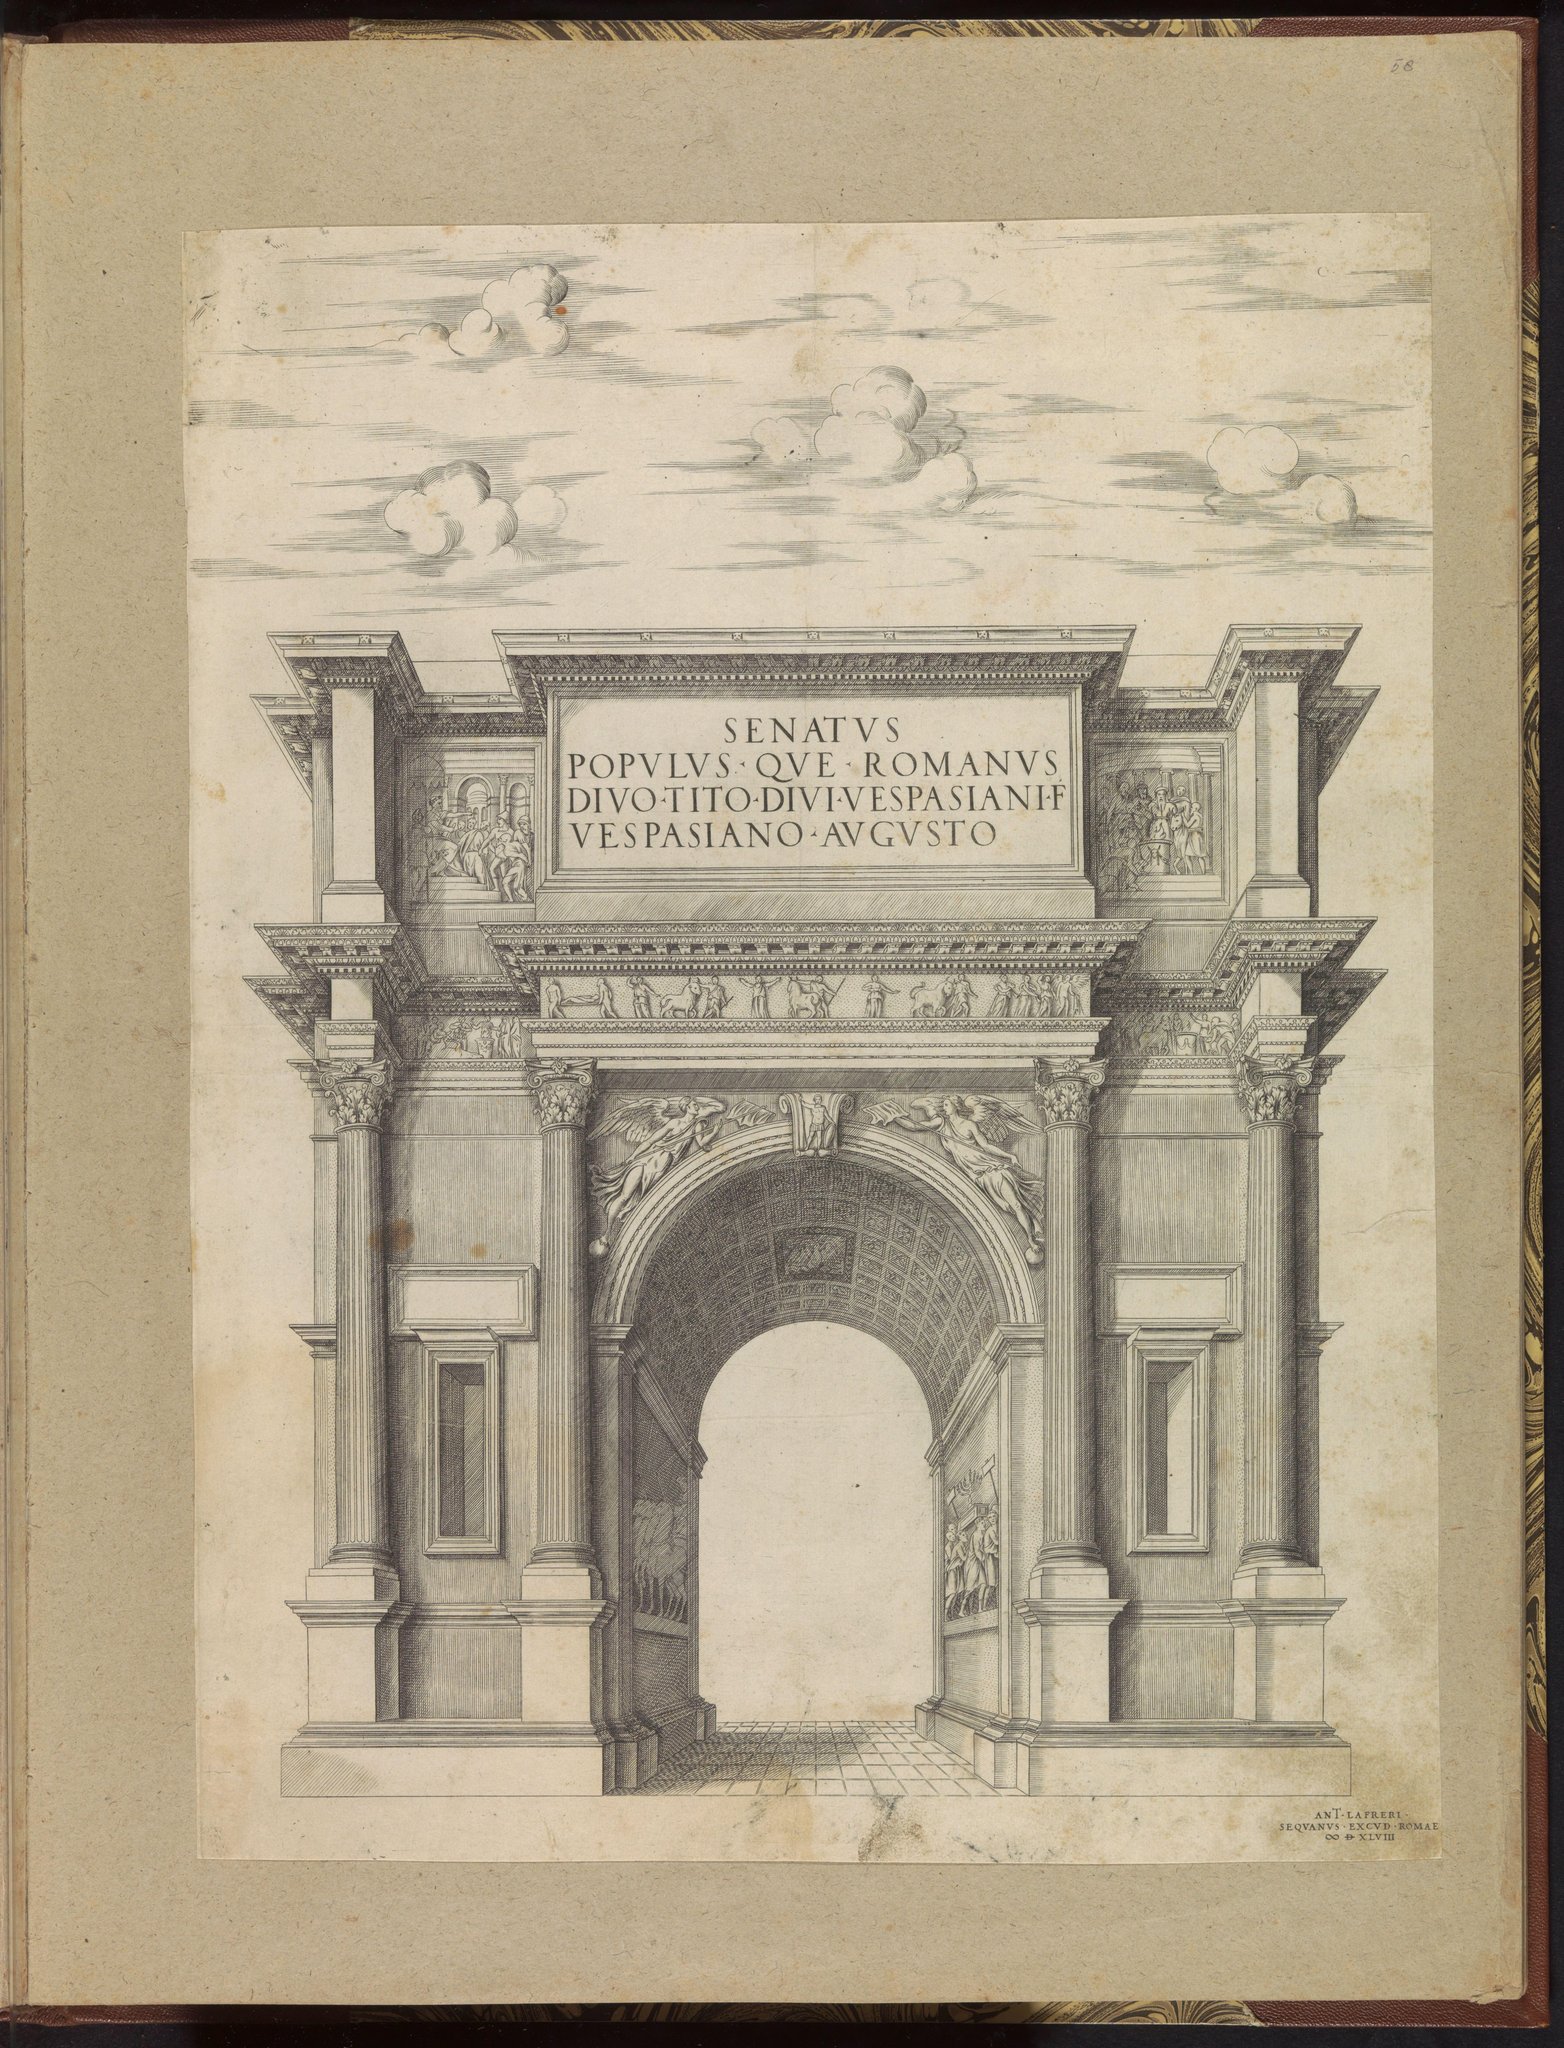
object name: album leaf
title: Speculum Romanae Magnificentiae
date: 1548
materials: paper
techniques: engraving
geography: rome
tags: triumphal arch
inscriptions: date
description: Kopie naar een prent uitgegeven door Antonio Salamanca. Deze prent behoort tot het prentcorpus dat bekend staat als de ‘Speculum Romanae Magnificentiae’ (‘Spiegel van Romeinse pracht’). Dit corpus, bestaande uit prenten met voorstellingen van kunstwerken en gebouwen uit het antieke en het moderne Rome, vond zijn oorsprong bij uitgevers Antonio Salamanca en Antonio Lafreri. Deze twee buitenlandse uitgevers bundelden hun krachten te Rome in de periode 1553-1563. Hun prenten werden al snel razend populair bij toeristen en verzamelaars, die de prenten individueel of in grote groepen aanschaften. Grote groepen Speculum-prenten werden vaak op aanvraag samengebonden in albums. Er zijn verschillende Speculum-albums overgeleverd die allemaal verschillen van inhoud. Tussen 1573 en 1577 gaf Antonio Lafreri een speciale titelpagina uit (met de titel ‘Speculum Romanae Magnificentiae’) die mensen voor hun verzamelingen konden voegen. Het overlijden van Lafreri in 1577 betekende niet het einde van het corpus. Een groot deel van de koperplaten ging over op Claudio en Stefano Duchetti. De rest raakte verspreid over verschillende andere uitgevers. De populariteit van de Speculum-prenten wist nog geruime periode uitgevers te inspireren tot het laten maken van kopieën en het toevoegen van nieuwe prenten aan het corpus.